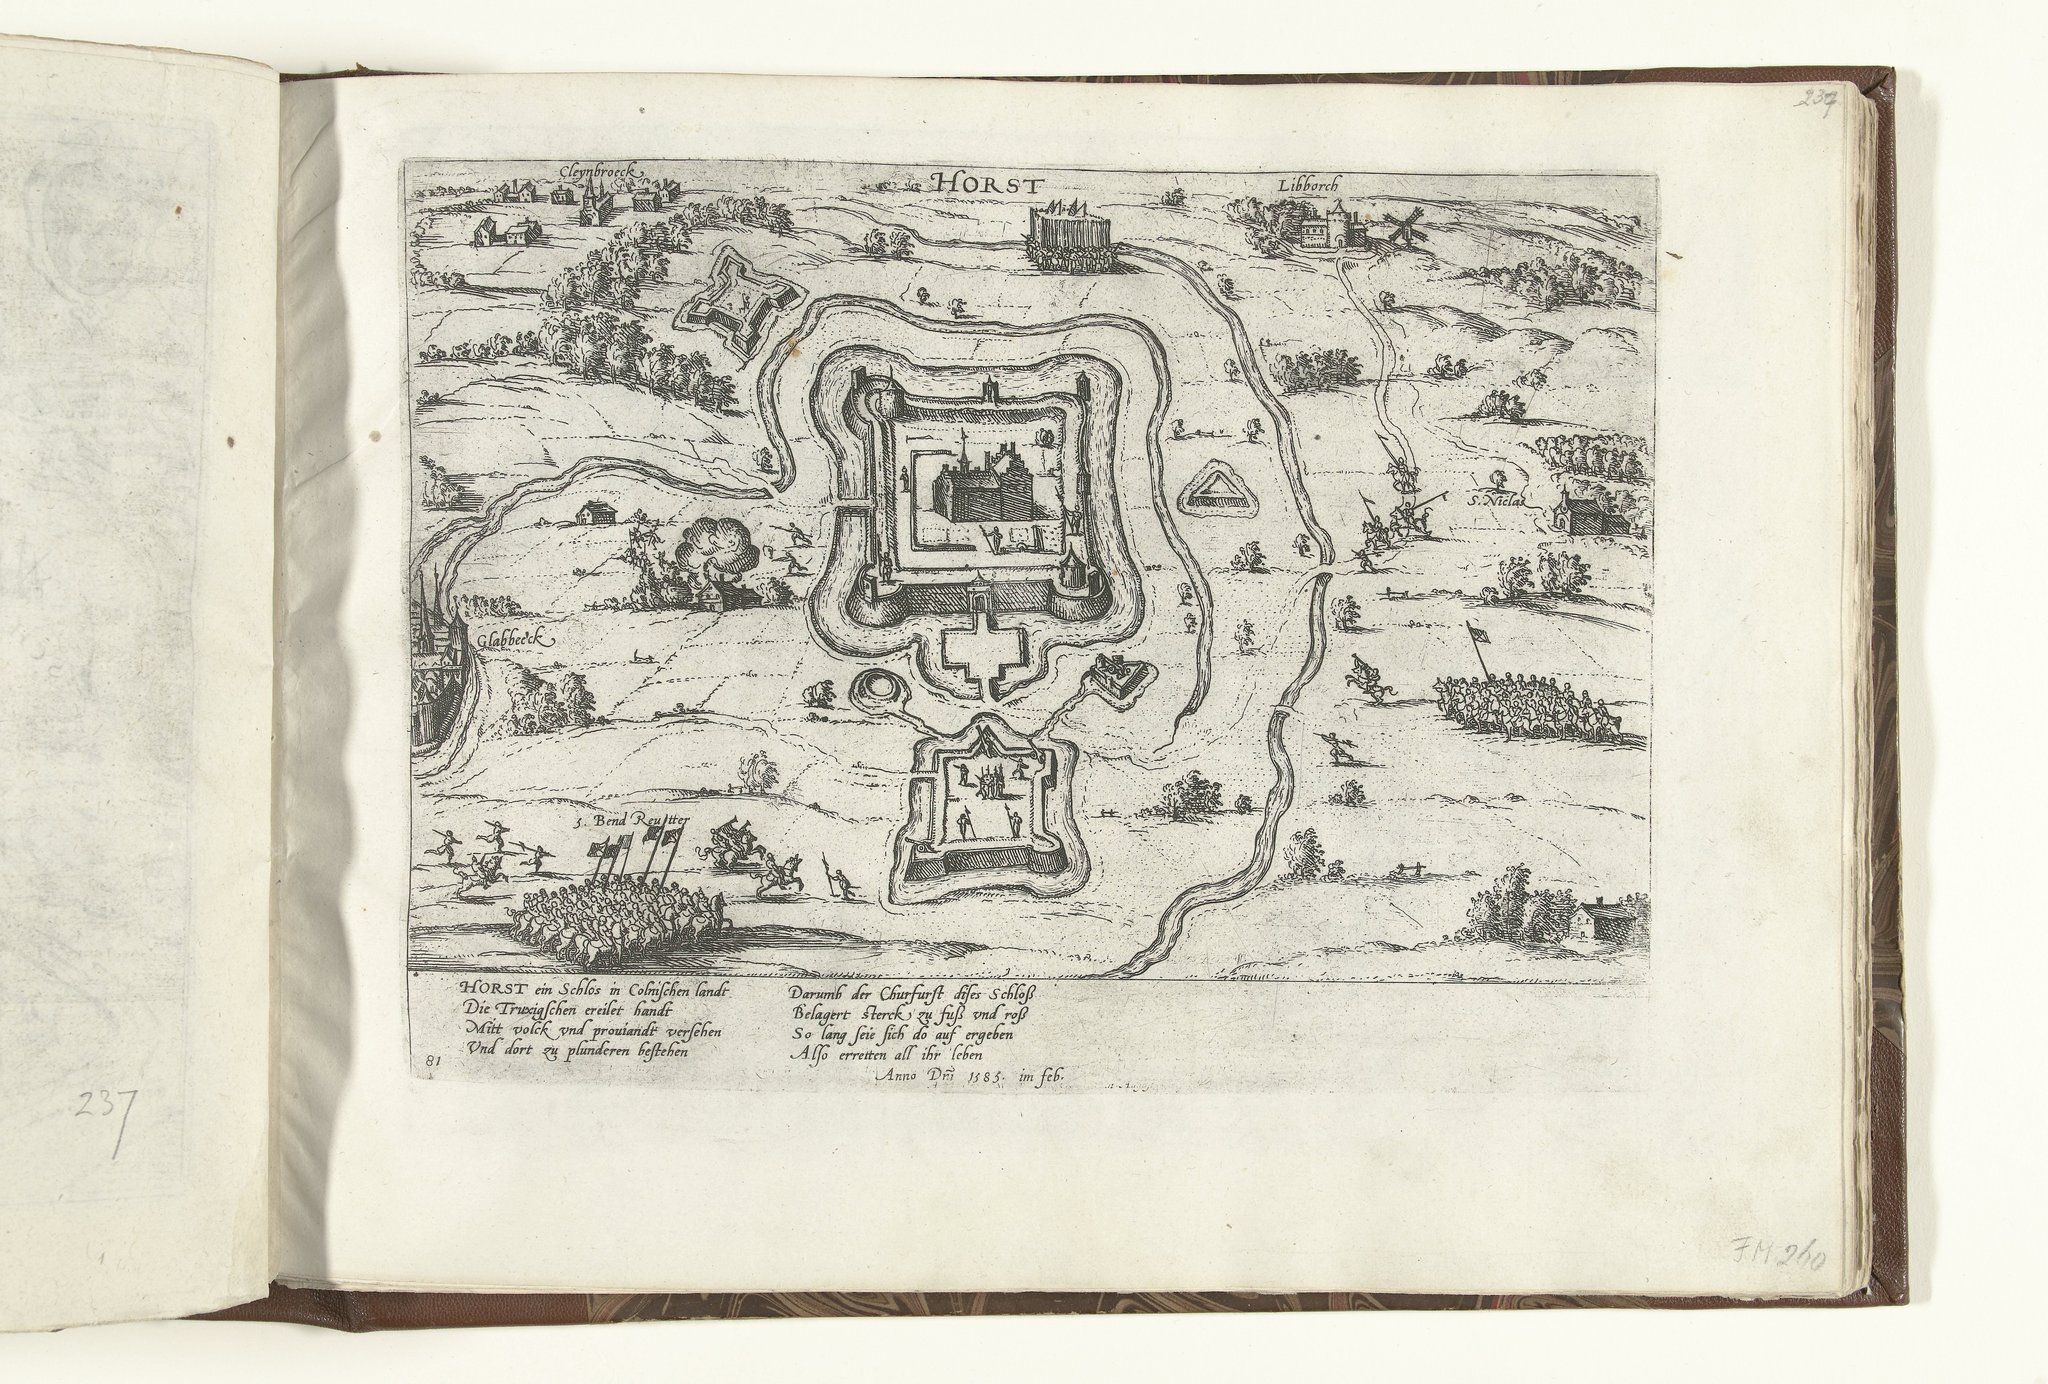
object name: print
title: Serie 9: Nederlandse en Duitse Gebeurtenissen, 1583-1587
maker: frans hogenberg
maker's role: print maker, publisher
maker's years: 1538-1590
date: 1585-1587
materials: paper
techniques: etching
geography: cologne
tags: bisschop, gebhard truchsess von waldburg, haus horst, keulse oorlog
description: Schloß Horst verloren voor Truchsess, februari 1585. Episode uit de Keulse Oorlog. Met onderschrift van 8 regels in het Duits. Genummerd: 81.